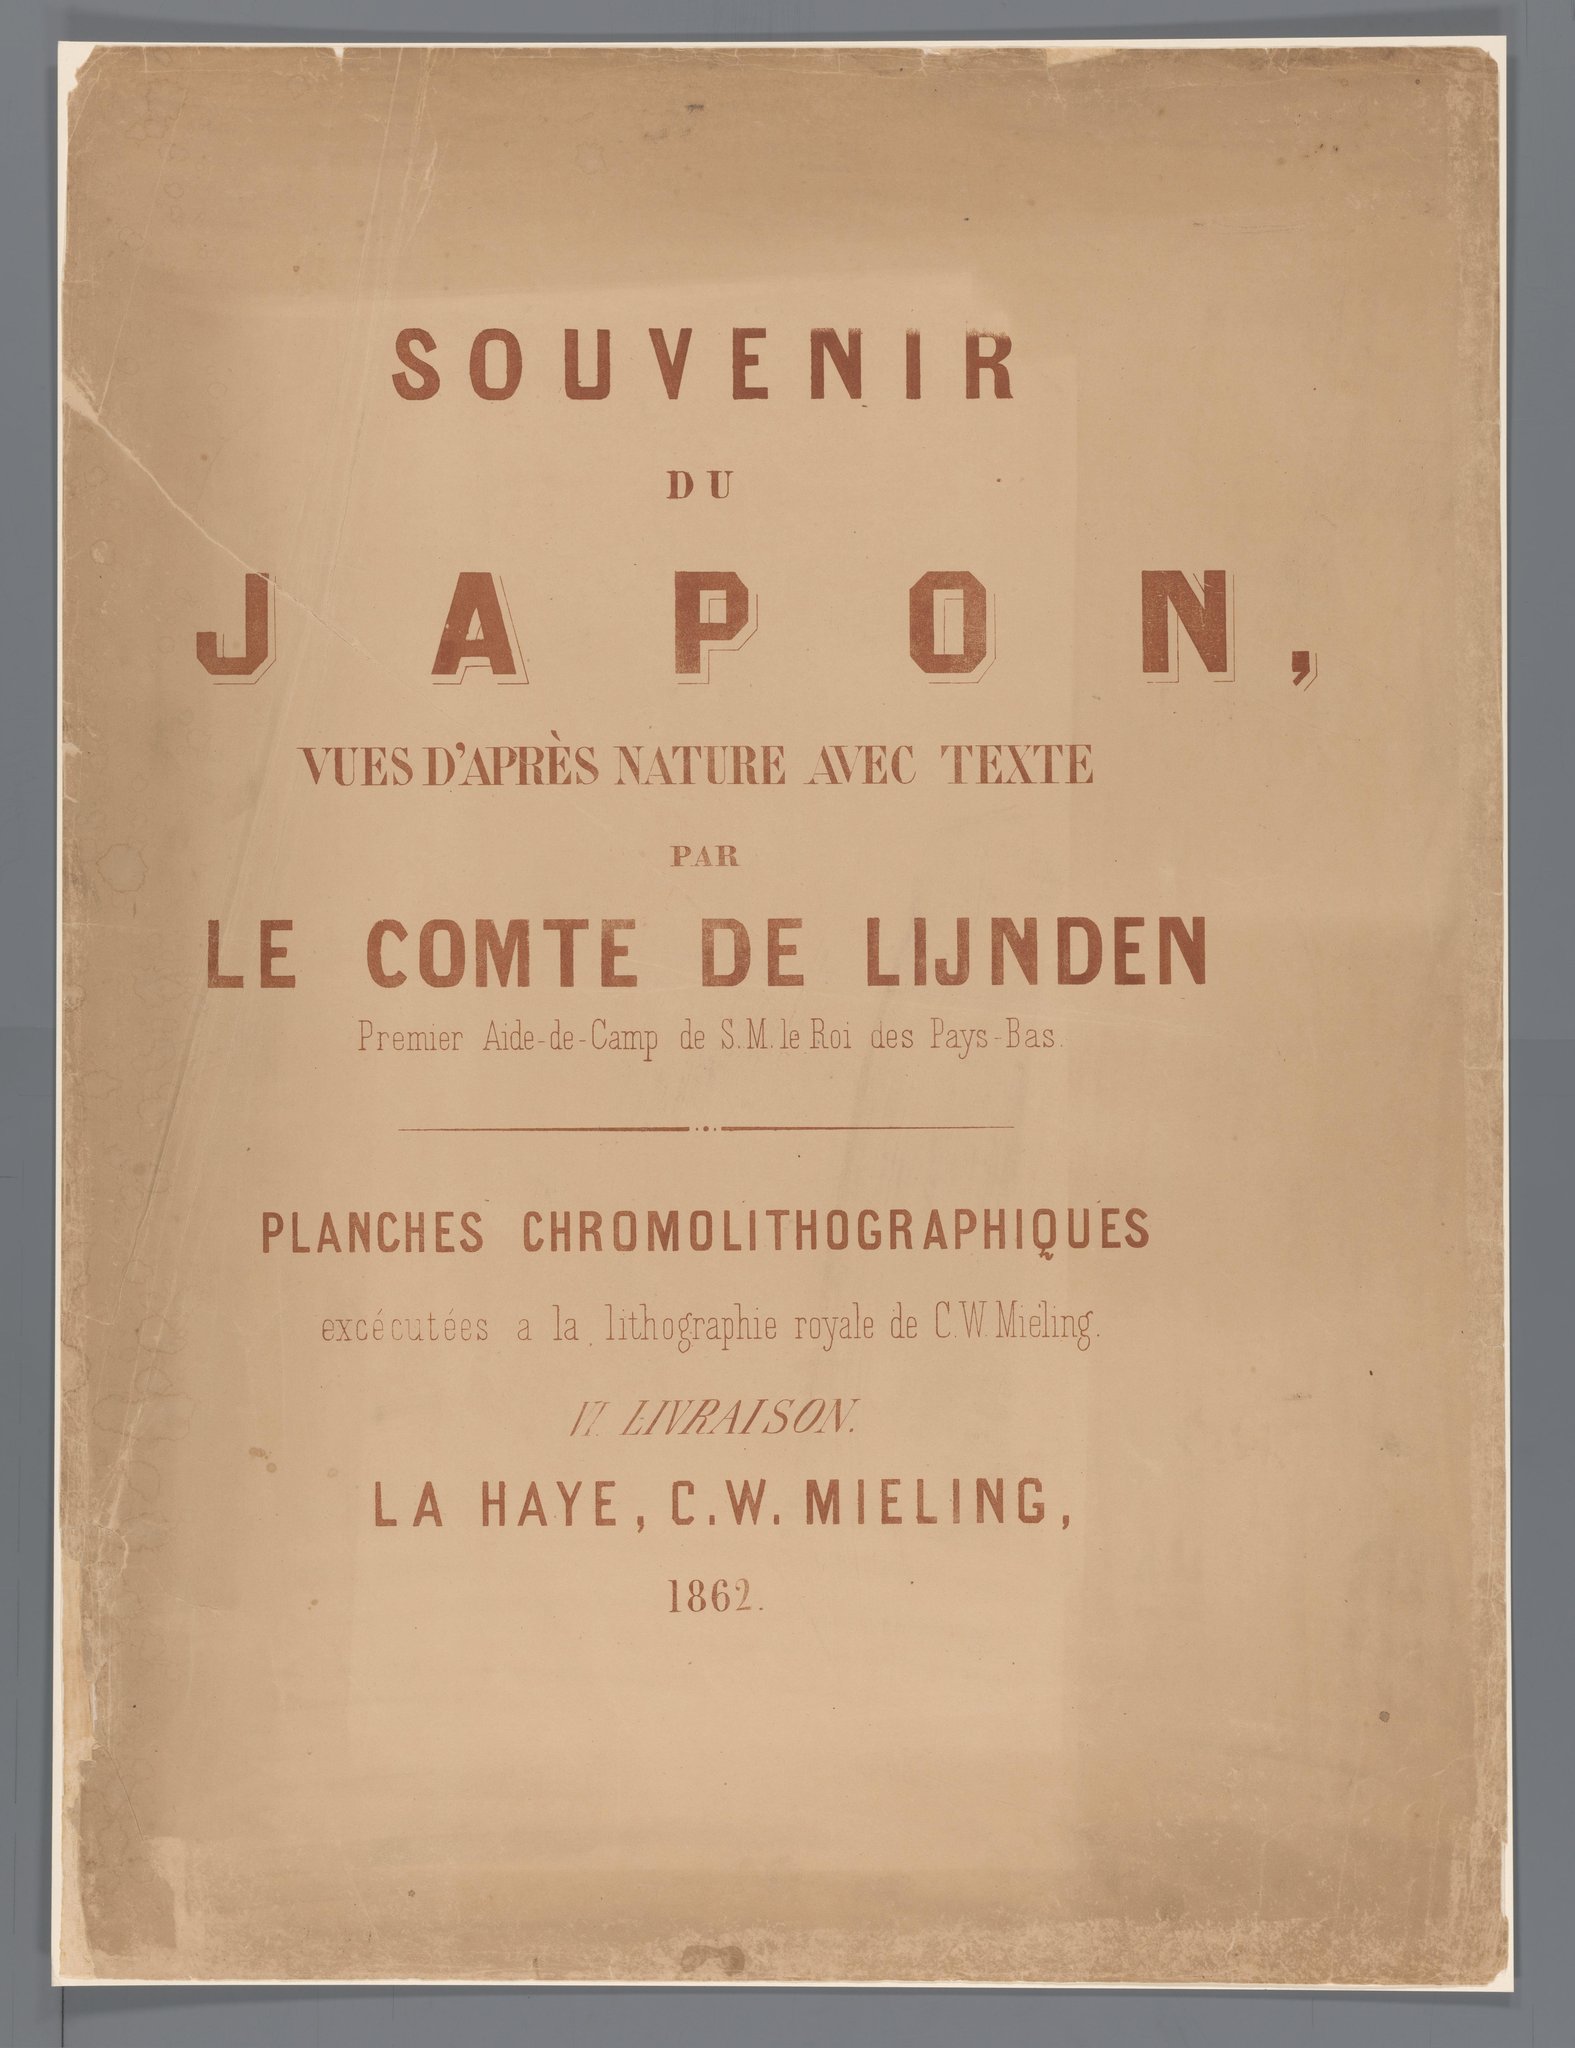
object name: titelprent, frontispice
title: Souvenir du Japon vues d'après nature avec texte par le comte de Lijnden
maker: carl wilhelm mieling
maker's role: print maker, printer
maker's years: 1815-1903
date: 1862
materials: paper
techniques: lithograph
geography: the hague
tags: japan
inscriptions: date